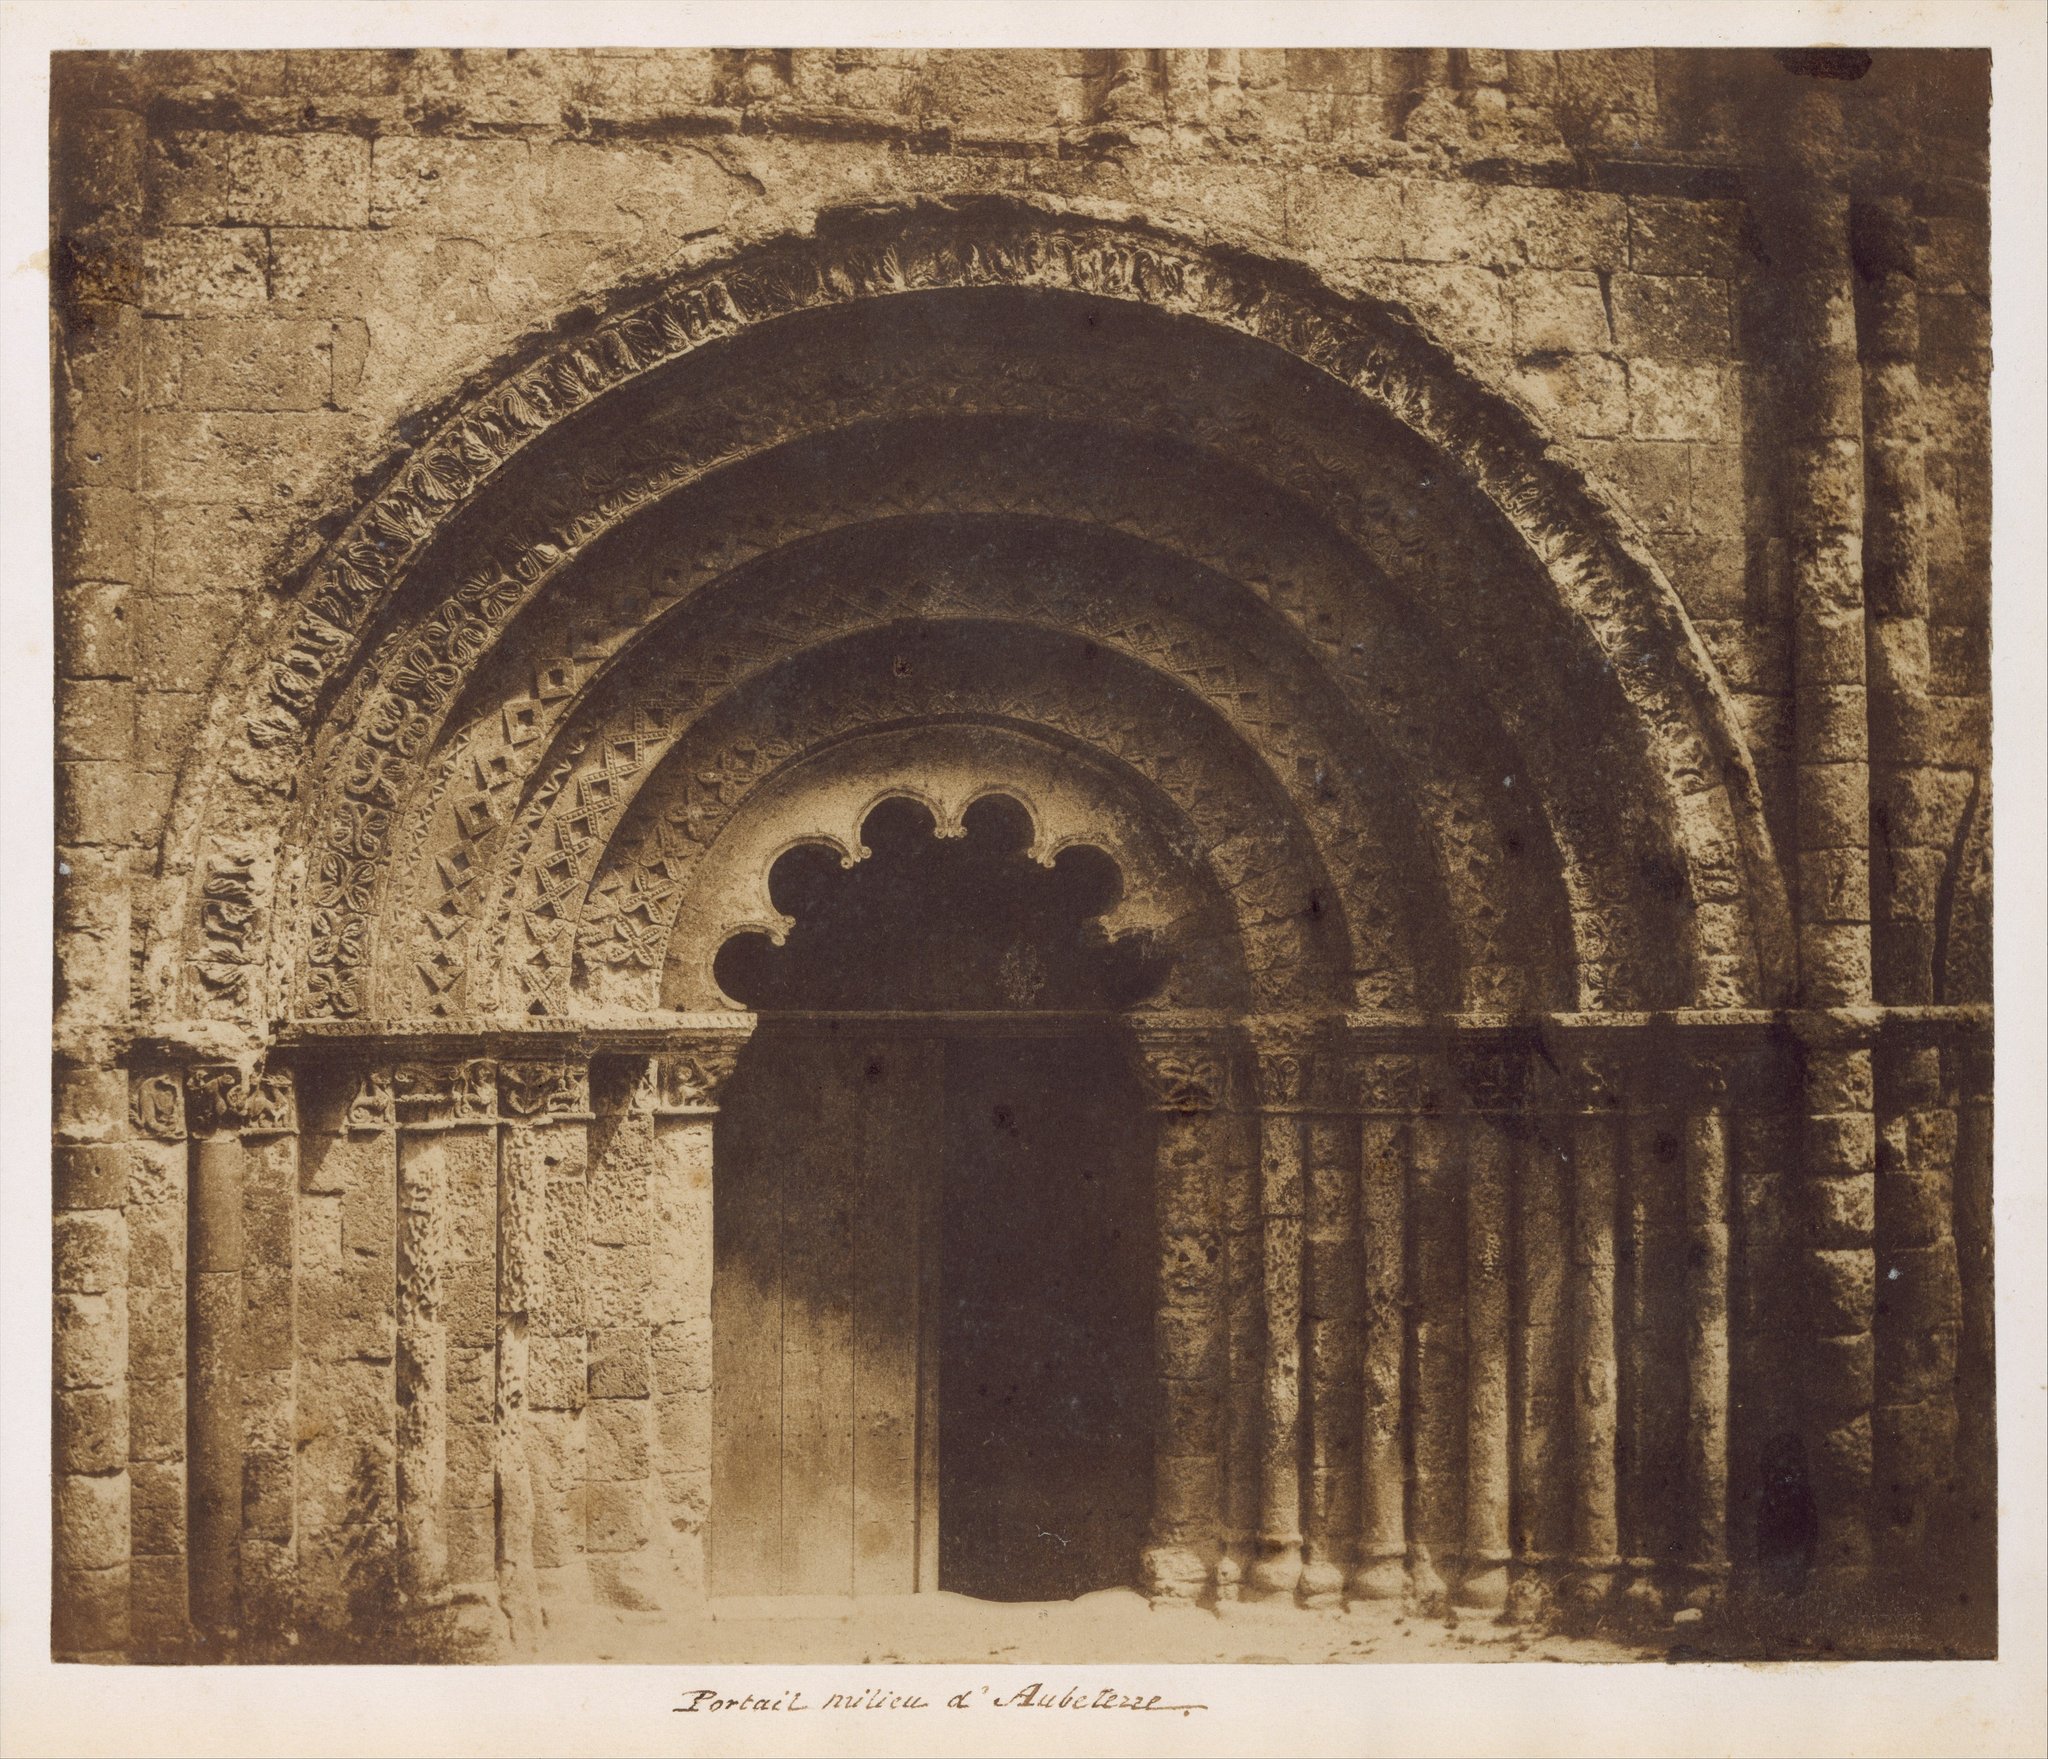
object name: photograph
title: Portail milieu d'Aubeterre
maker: gustave le gray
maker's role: artist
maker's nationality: french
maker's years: 1820-1884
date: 1851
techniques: paper negative, salted paper print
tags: architecture,arches,doors,churches